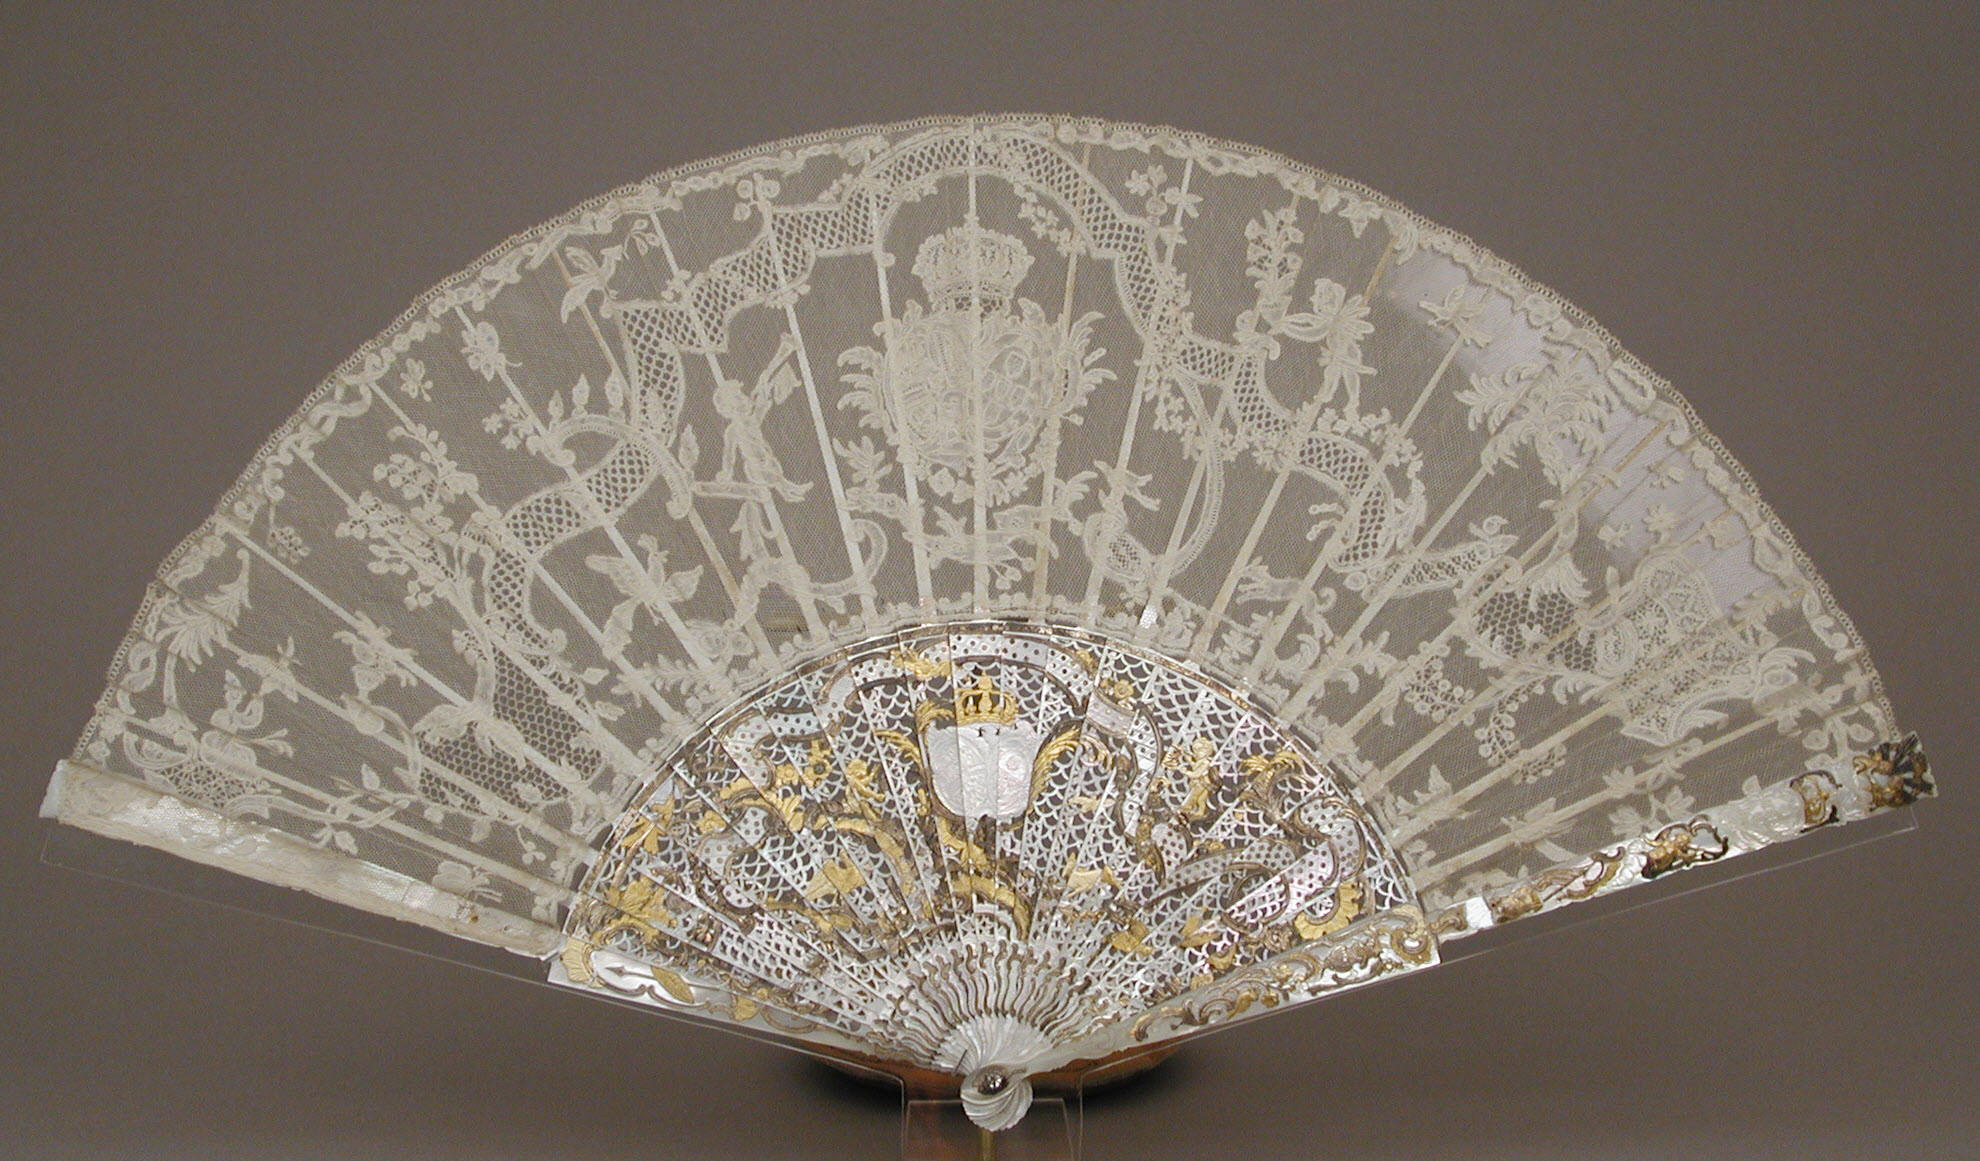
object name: fan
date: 1734-1766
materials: diamond, gold, mother of pearl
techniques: lace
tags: coat of arms